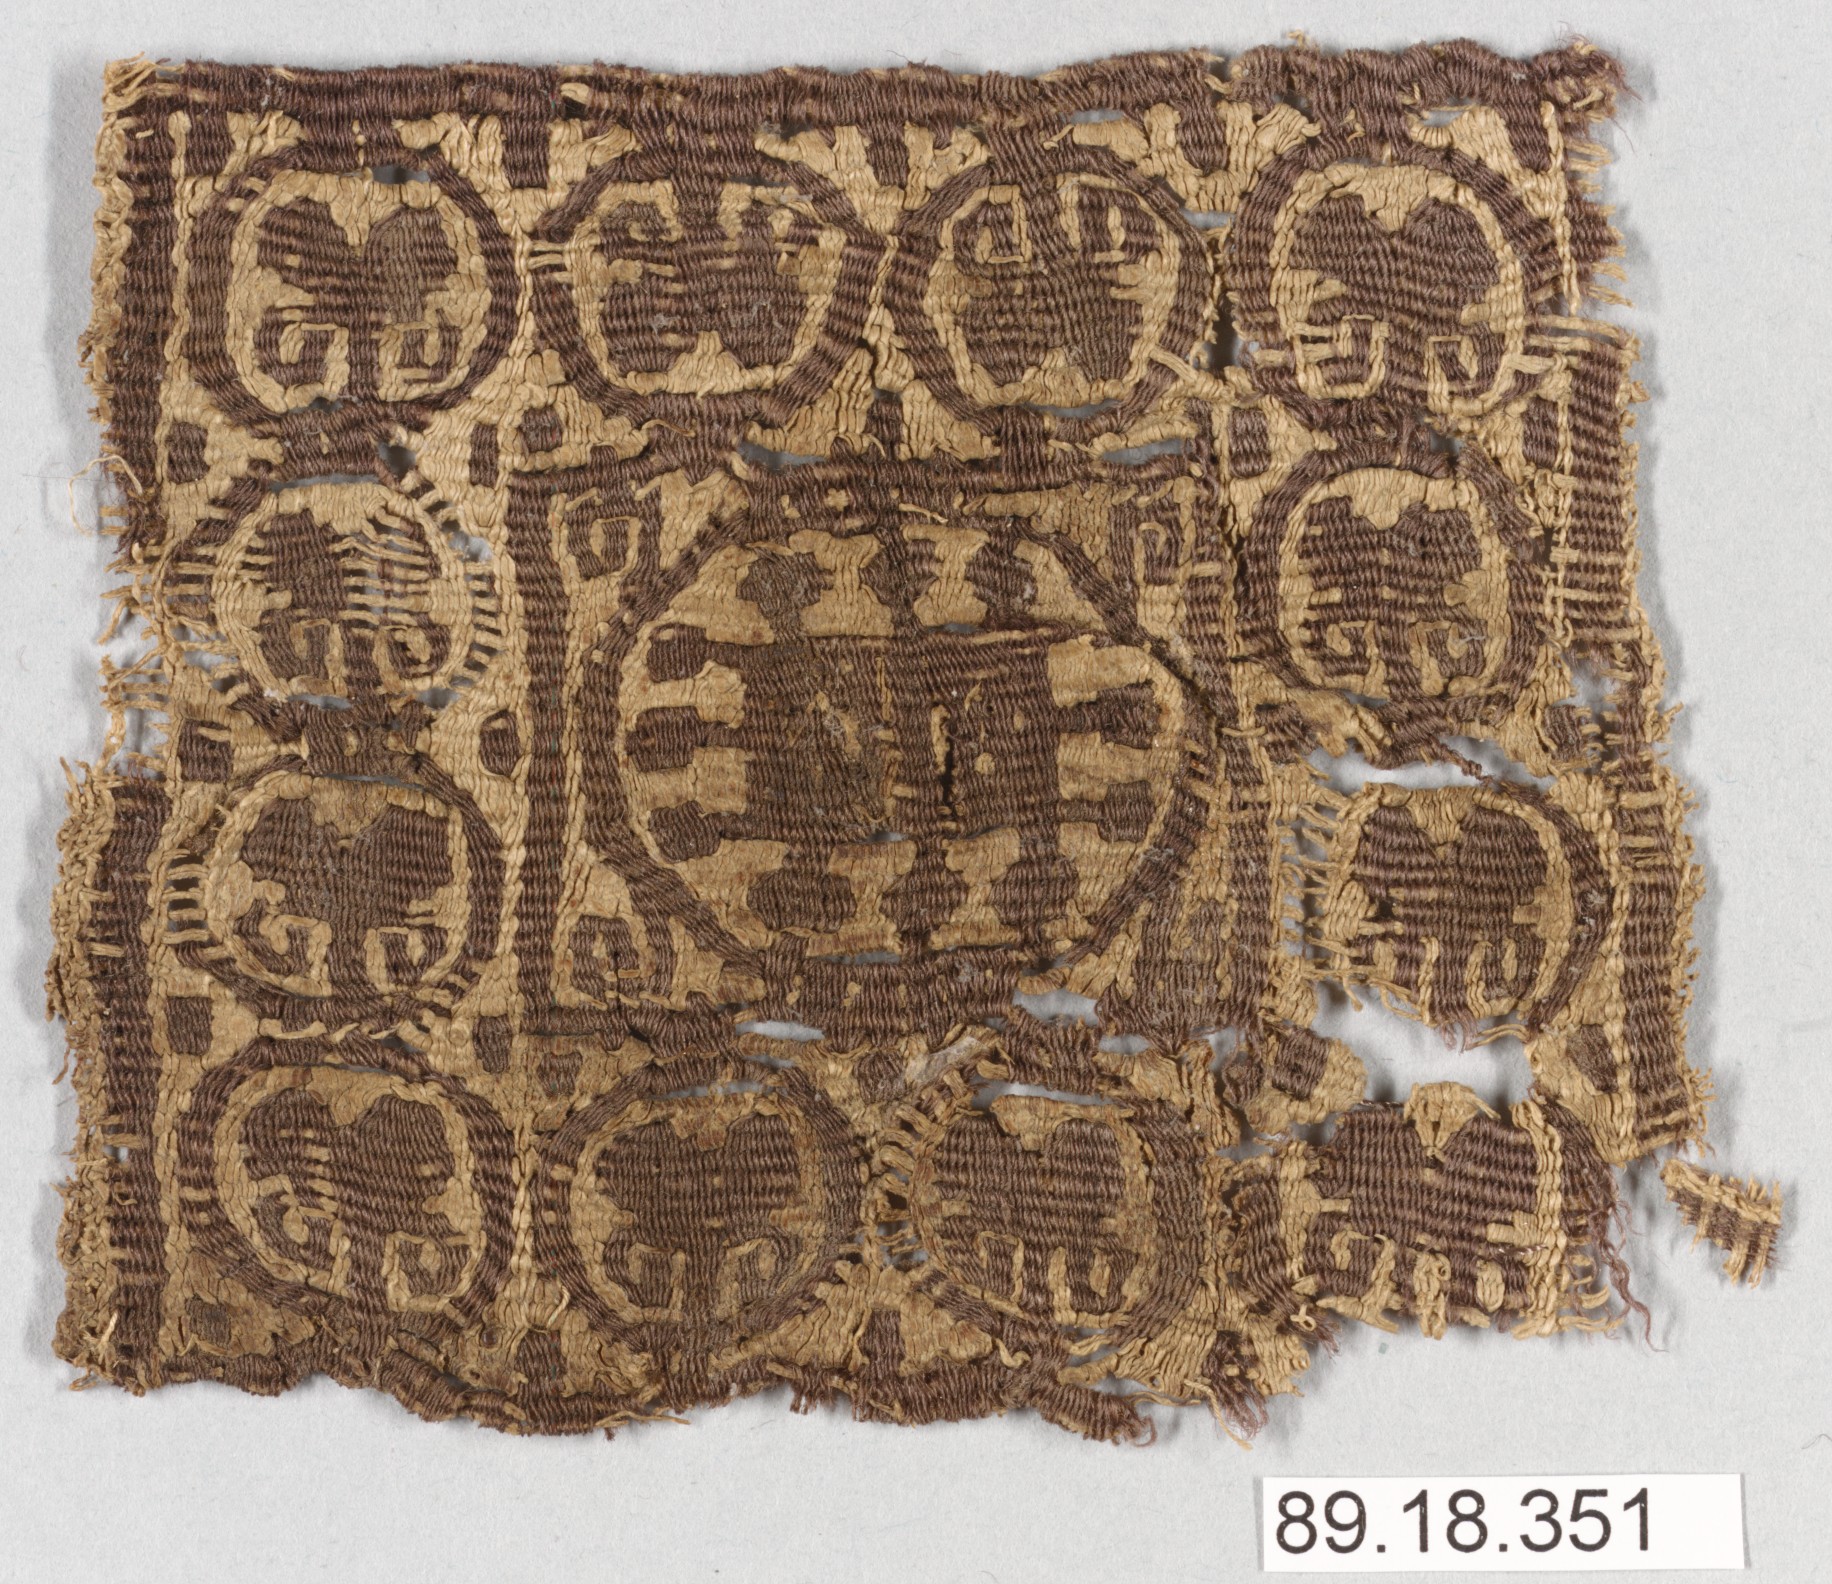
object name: textile fragment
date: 201-400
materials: linen, wool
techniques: weave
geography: egypt